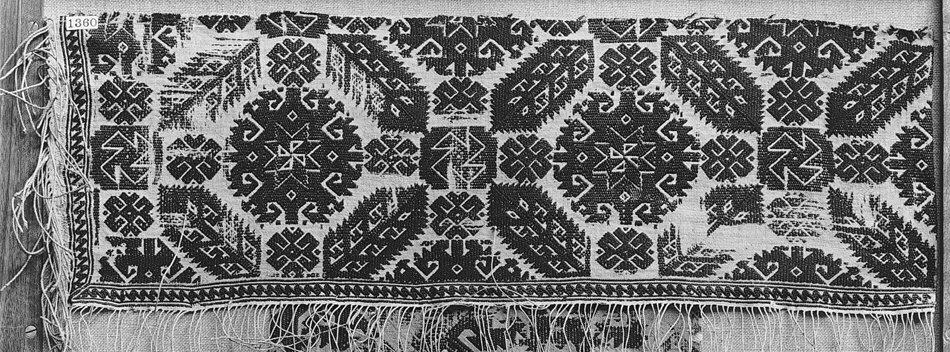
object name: fragment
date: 1701-1800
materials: linen, silk